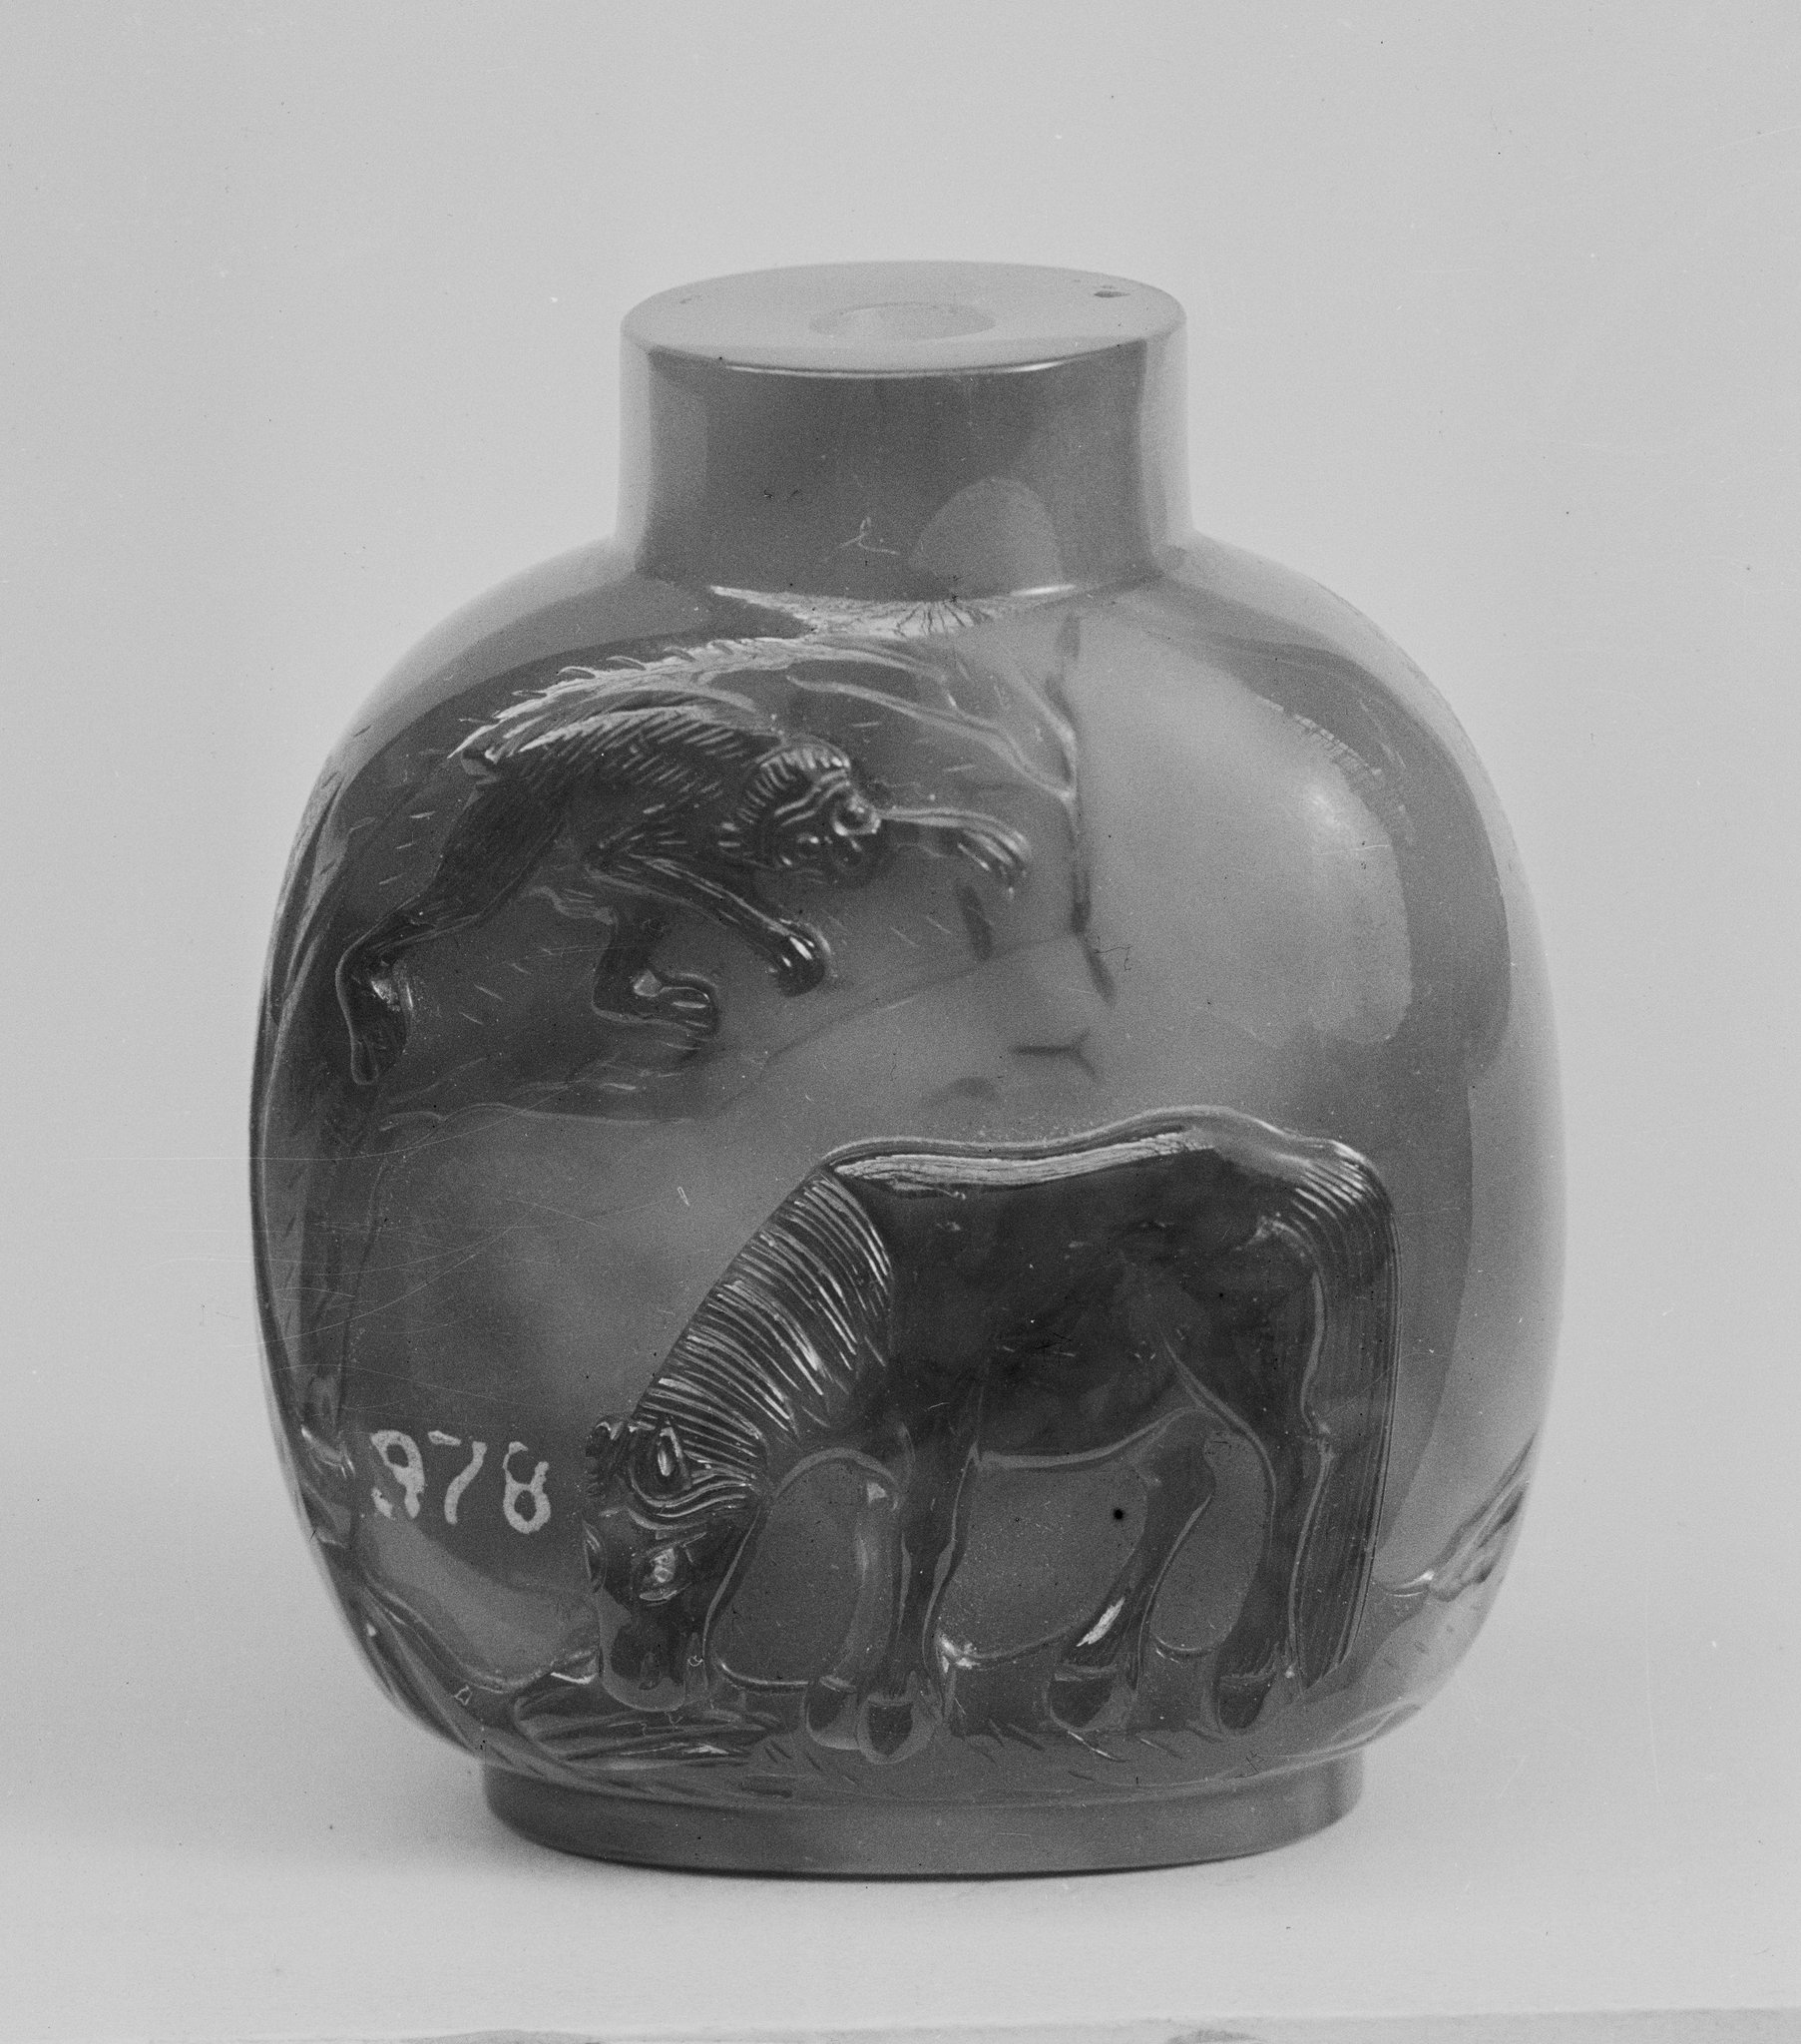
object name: snuff bottle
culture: chinese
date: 1701-1900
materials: stone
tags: horses,monkeys